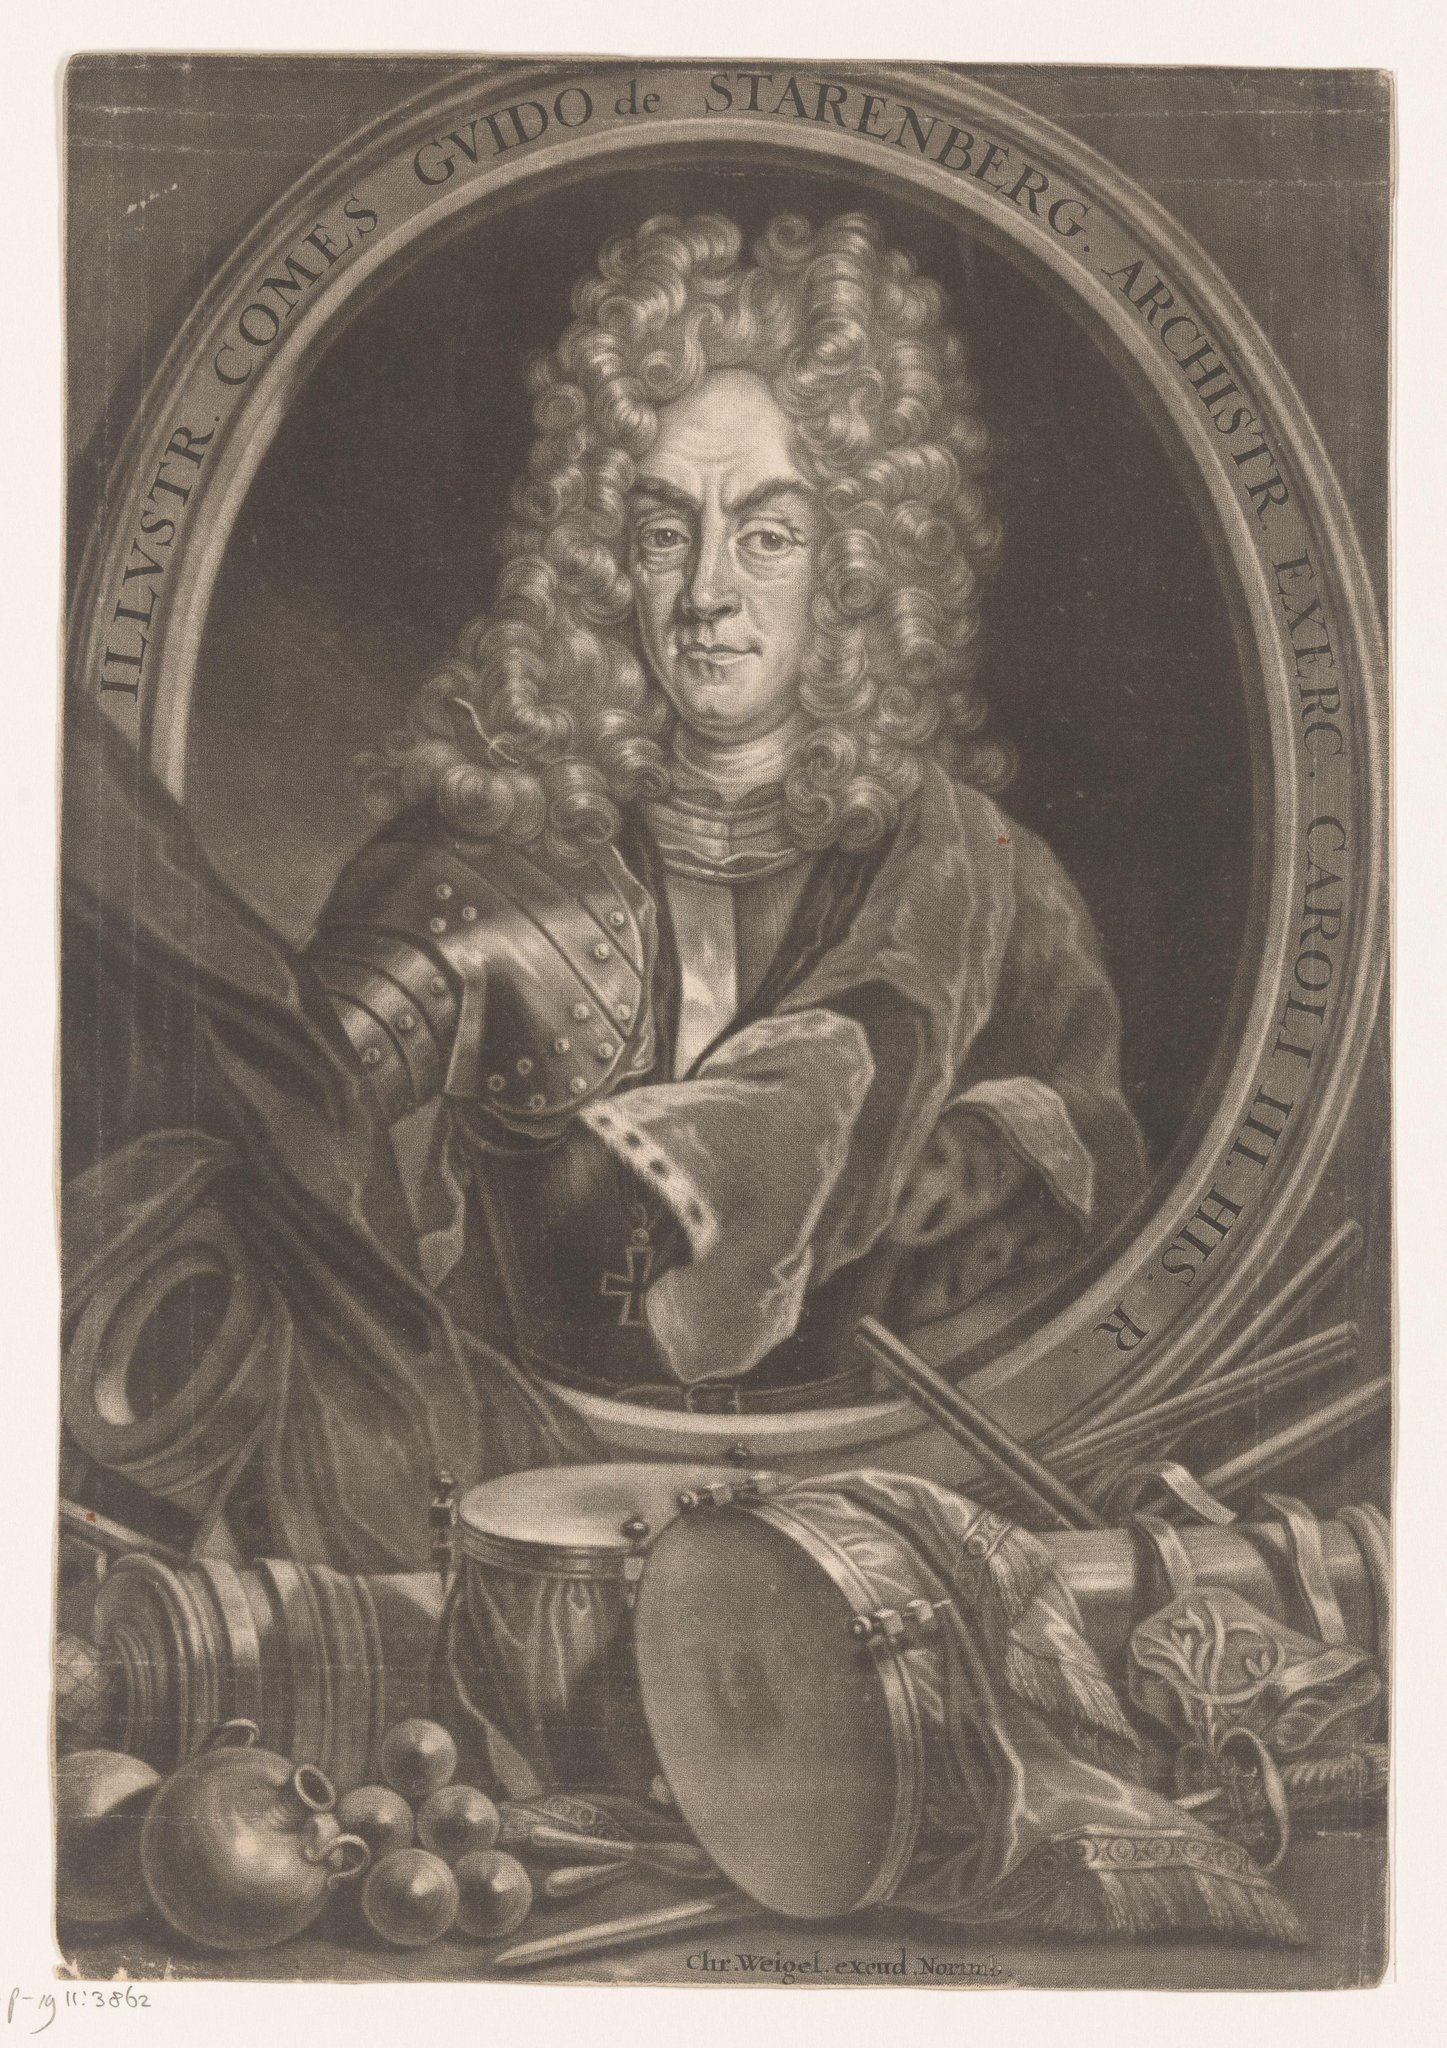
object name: print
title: Portret van Guido, Graf Starhemberg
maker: christoph weigel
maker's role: goldsmith, print maker, publisher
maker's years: 1654-1725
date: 1692-1725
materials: paper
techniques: mezzotint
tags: historical persons, armorial bearing, heraldry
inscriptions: collector's mark: Lugt 2228